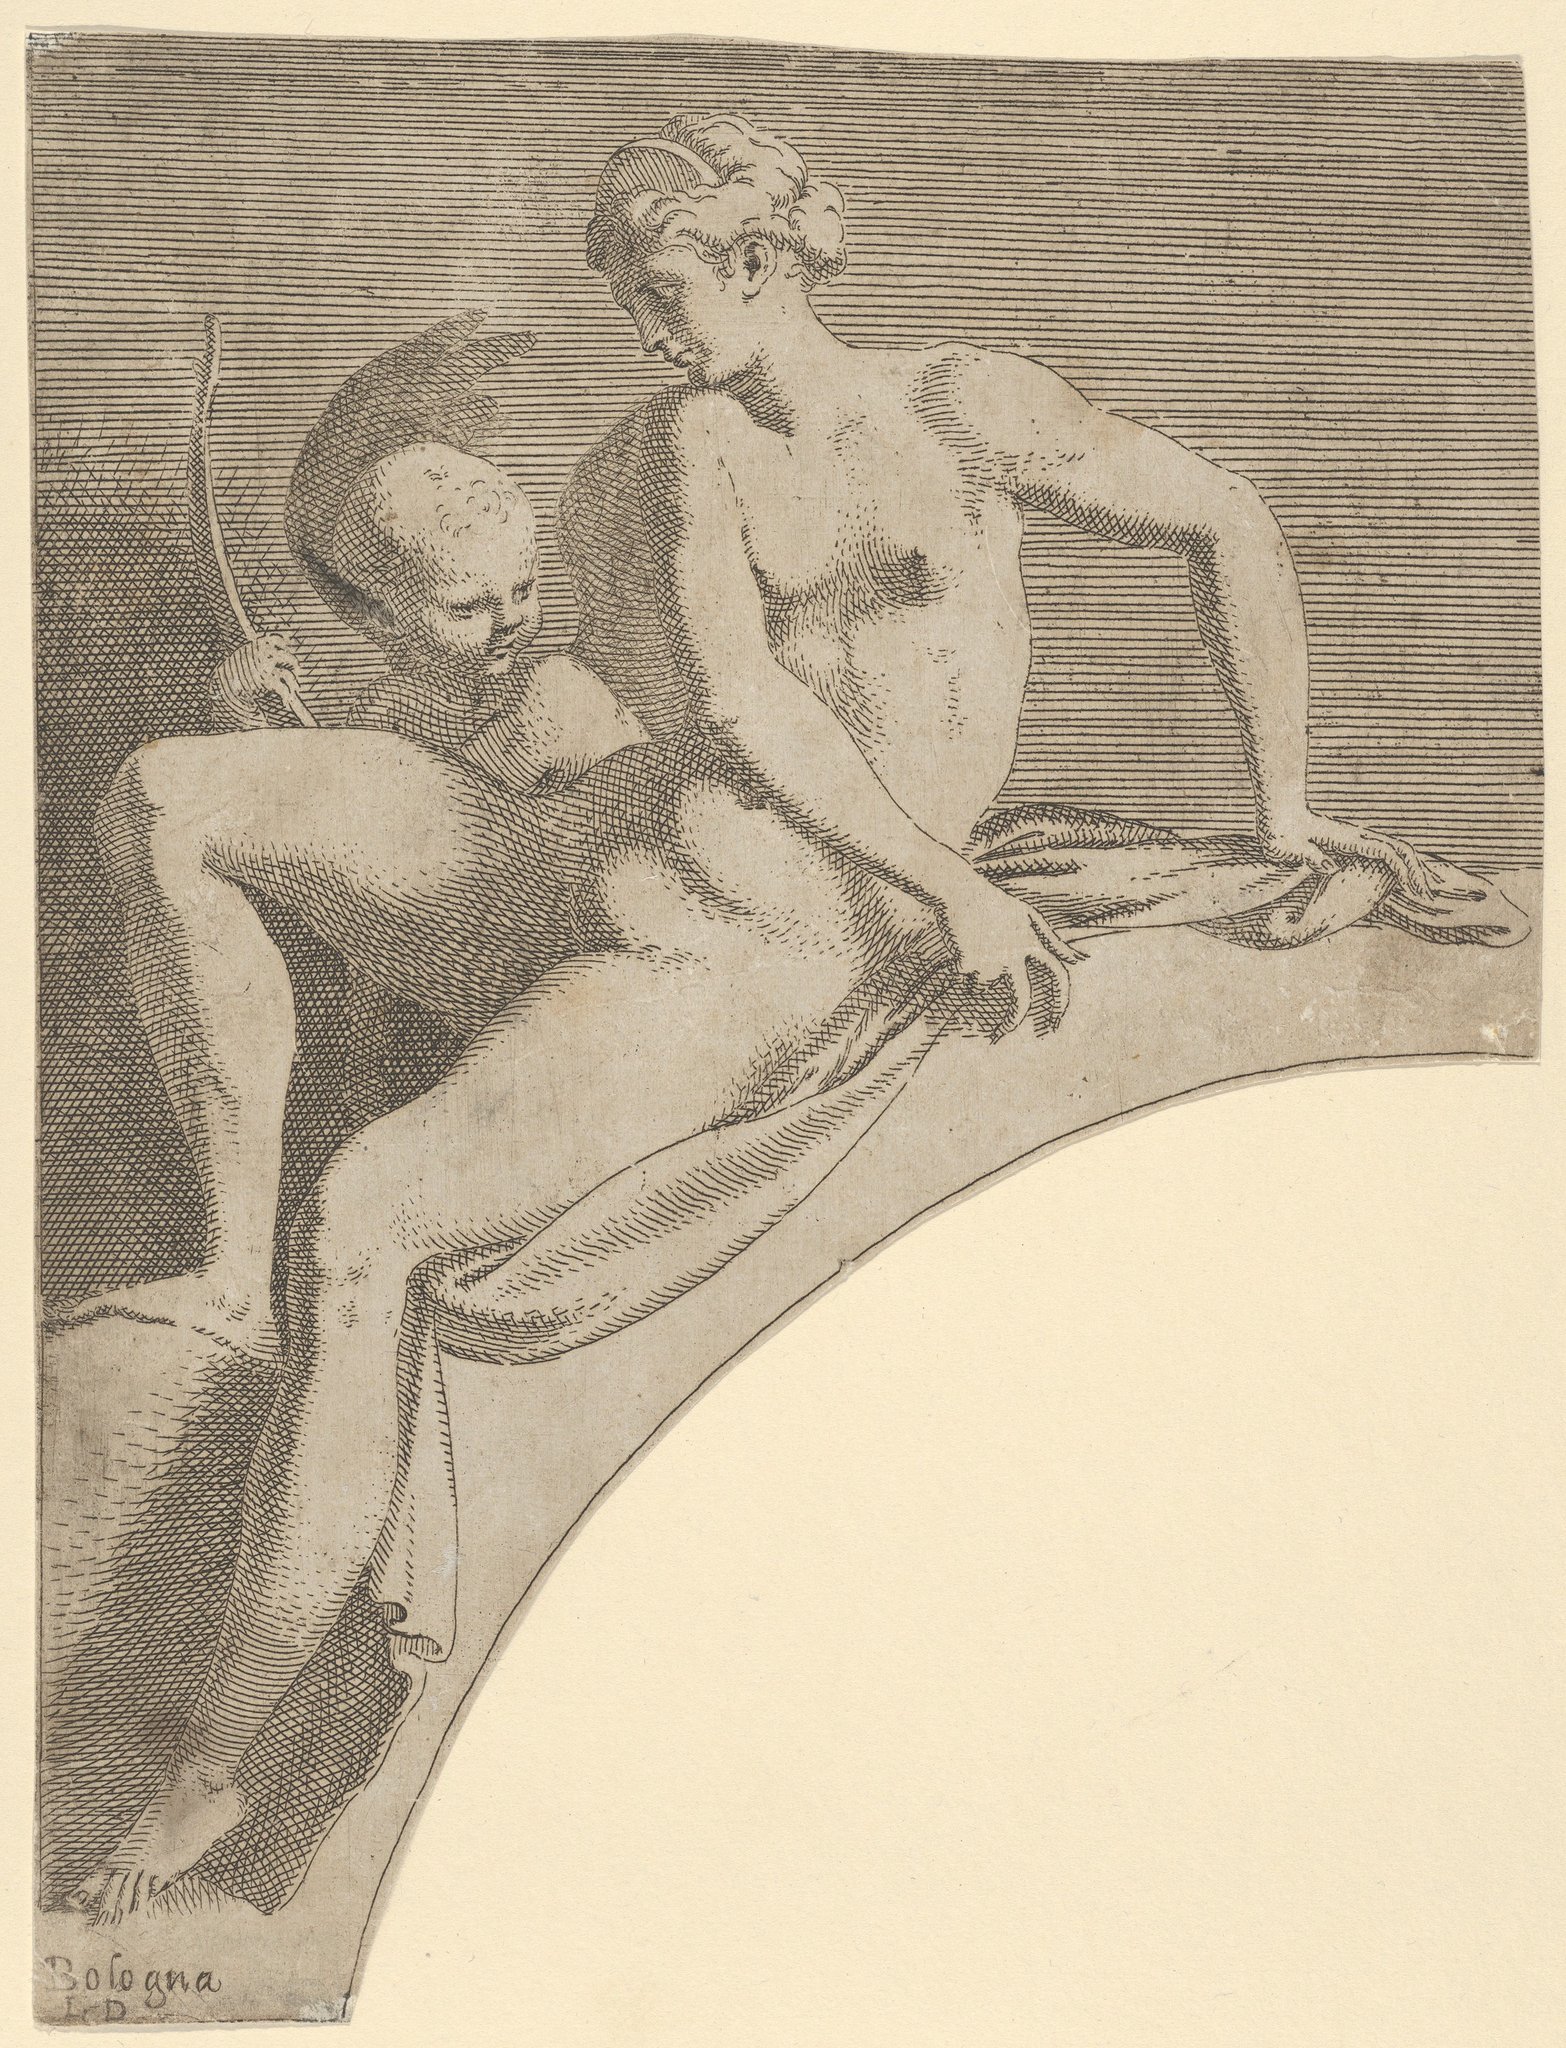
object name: print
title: Venus, from "Twelve Muses and Goddesses"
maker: léon davent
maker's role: artist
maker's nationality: french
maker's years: 1540-1556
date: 1540-1556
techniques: etching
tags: venus